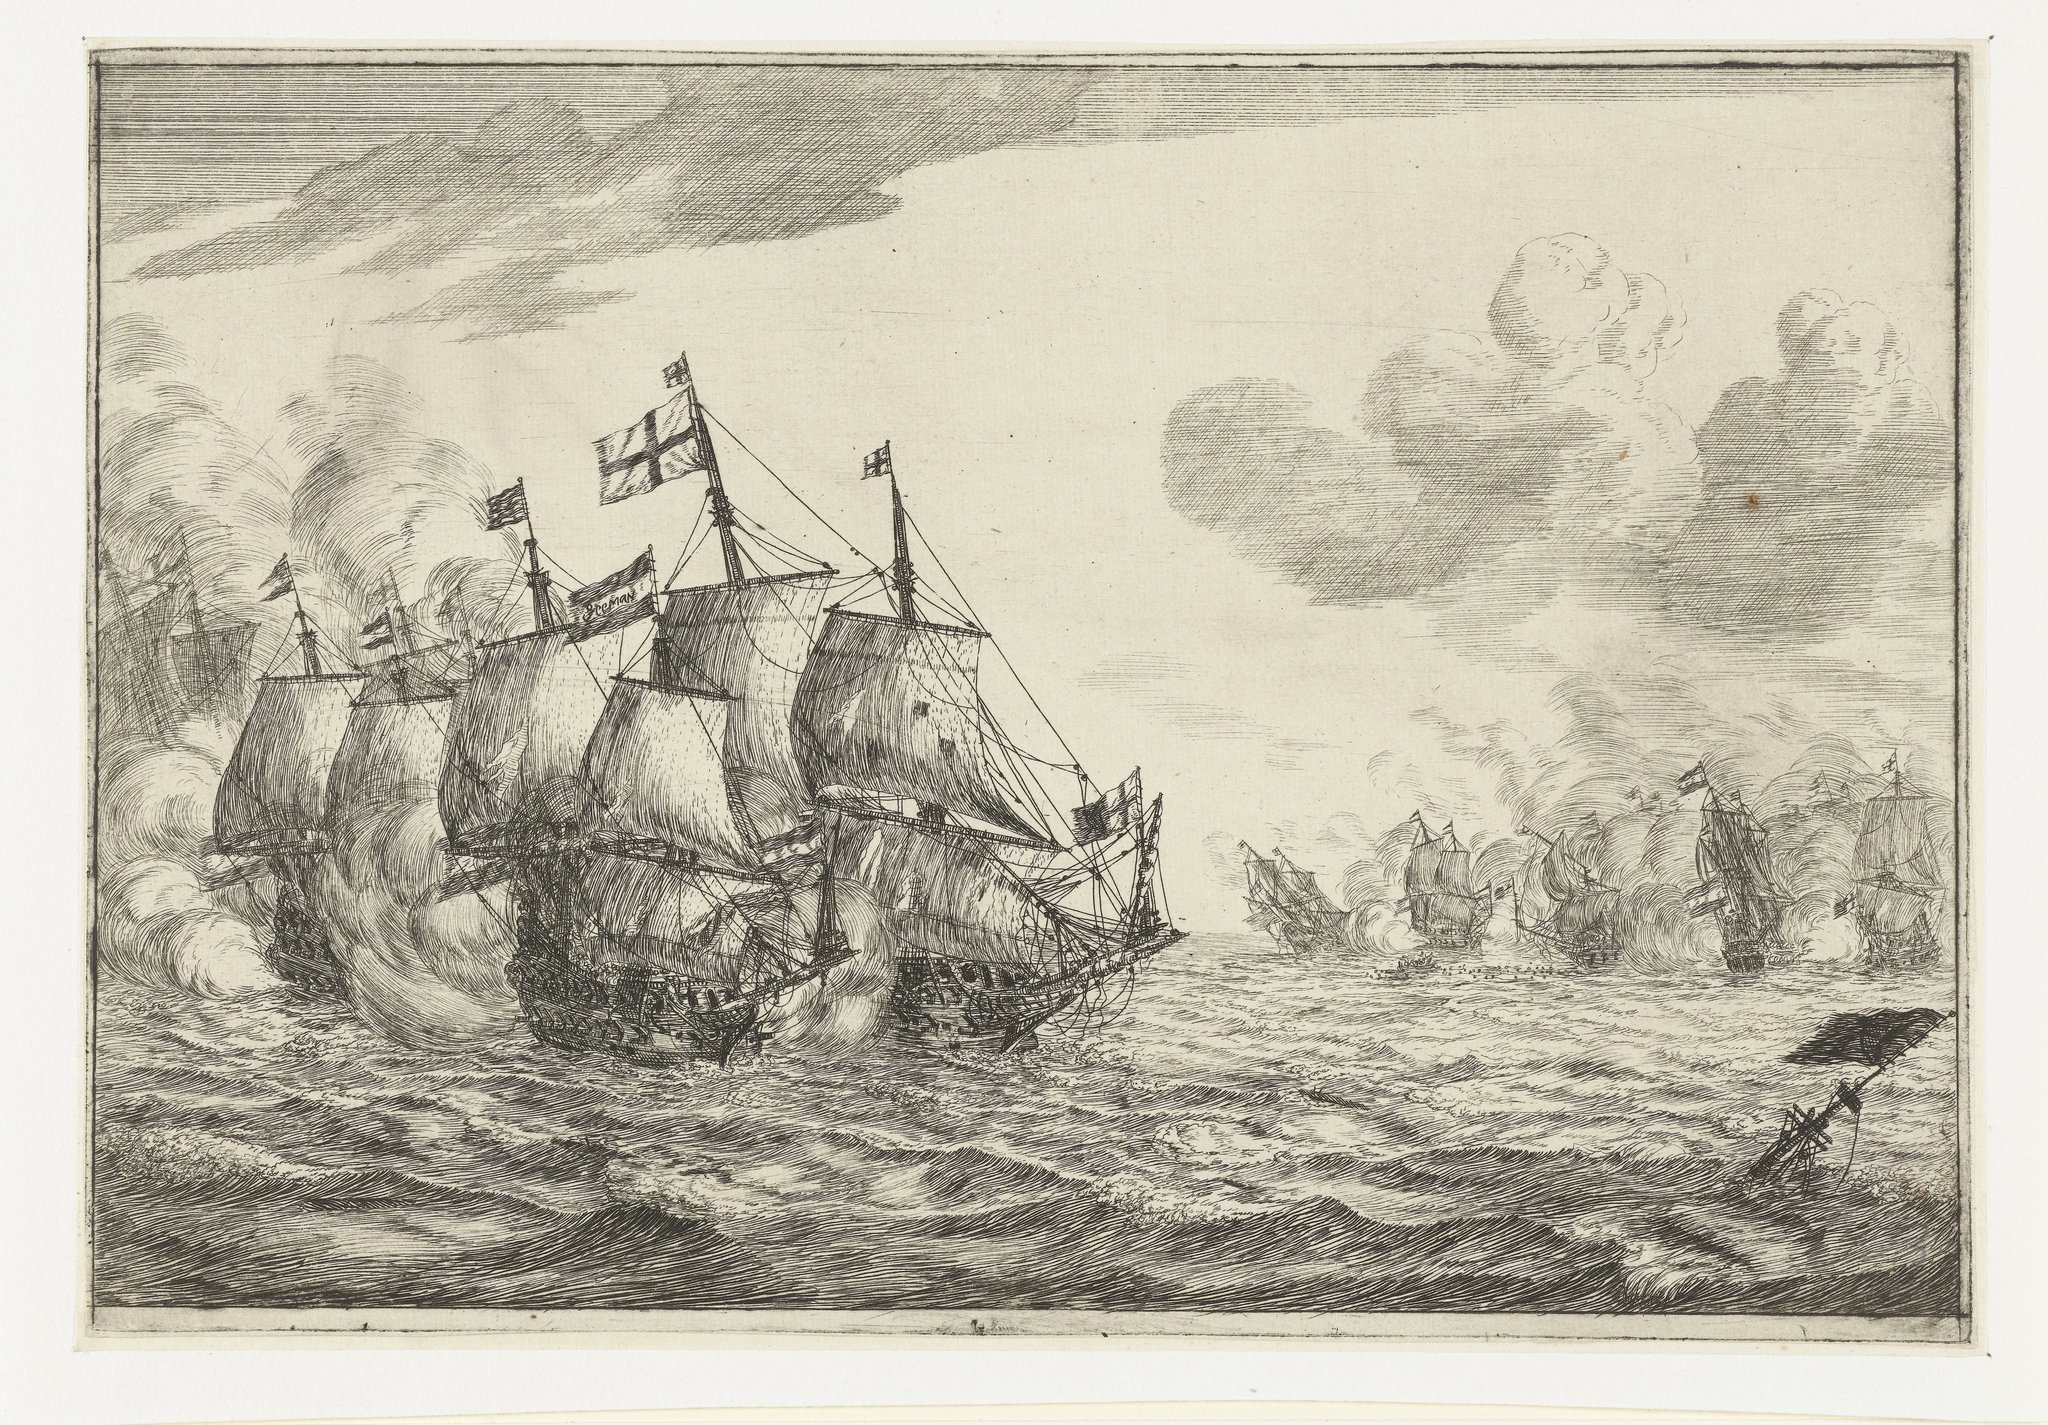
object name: print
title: Zeeslag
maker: reinier nooms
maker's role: draughtsman, painter, print maker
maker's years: 1623-1664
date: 1652-1656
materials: paper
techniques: drypoint, etching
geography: netherlands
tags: warfare; military affairs (+ sailing-ships), battle, fighting in general (+ naval force)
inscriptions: number: ‘3’, collector's mark: Lugt 240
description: Twee zware gevechten tussen Nederlandse en Engelse schepen.